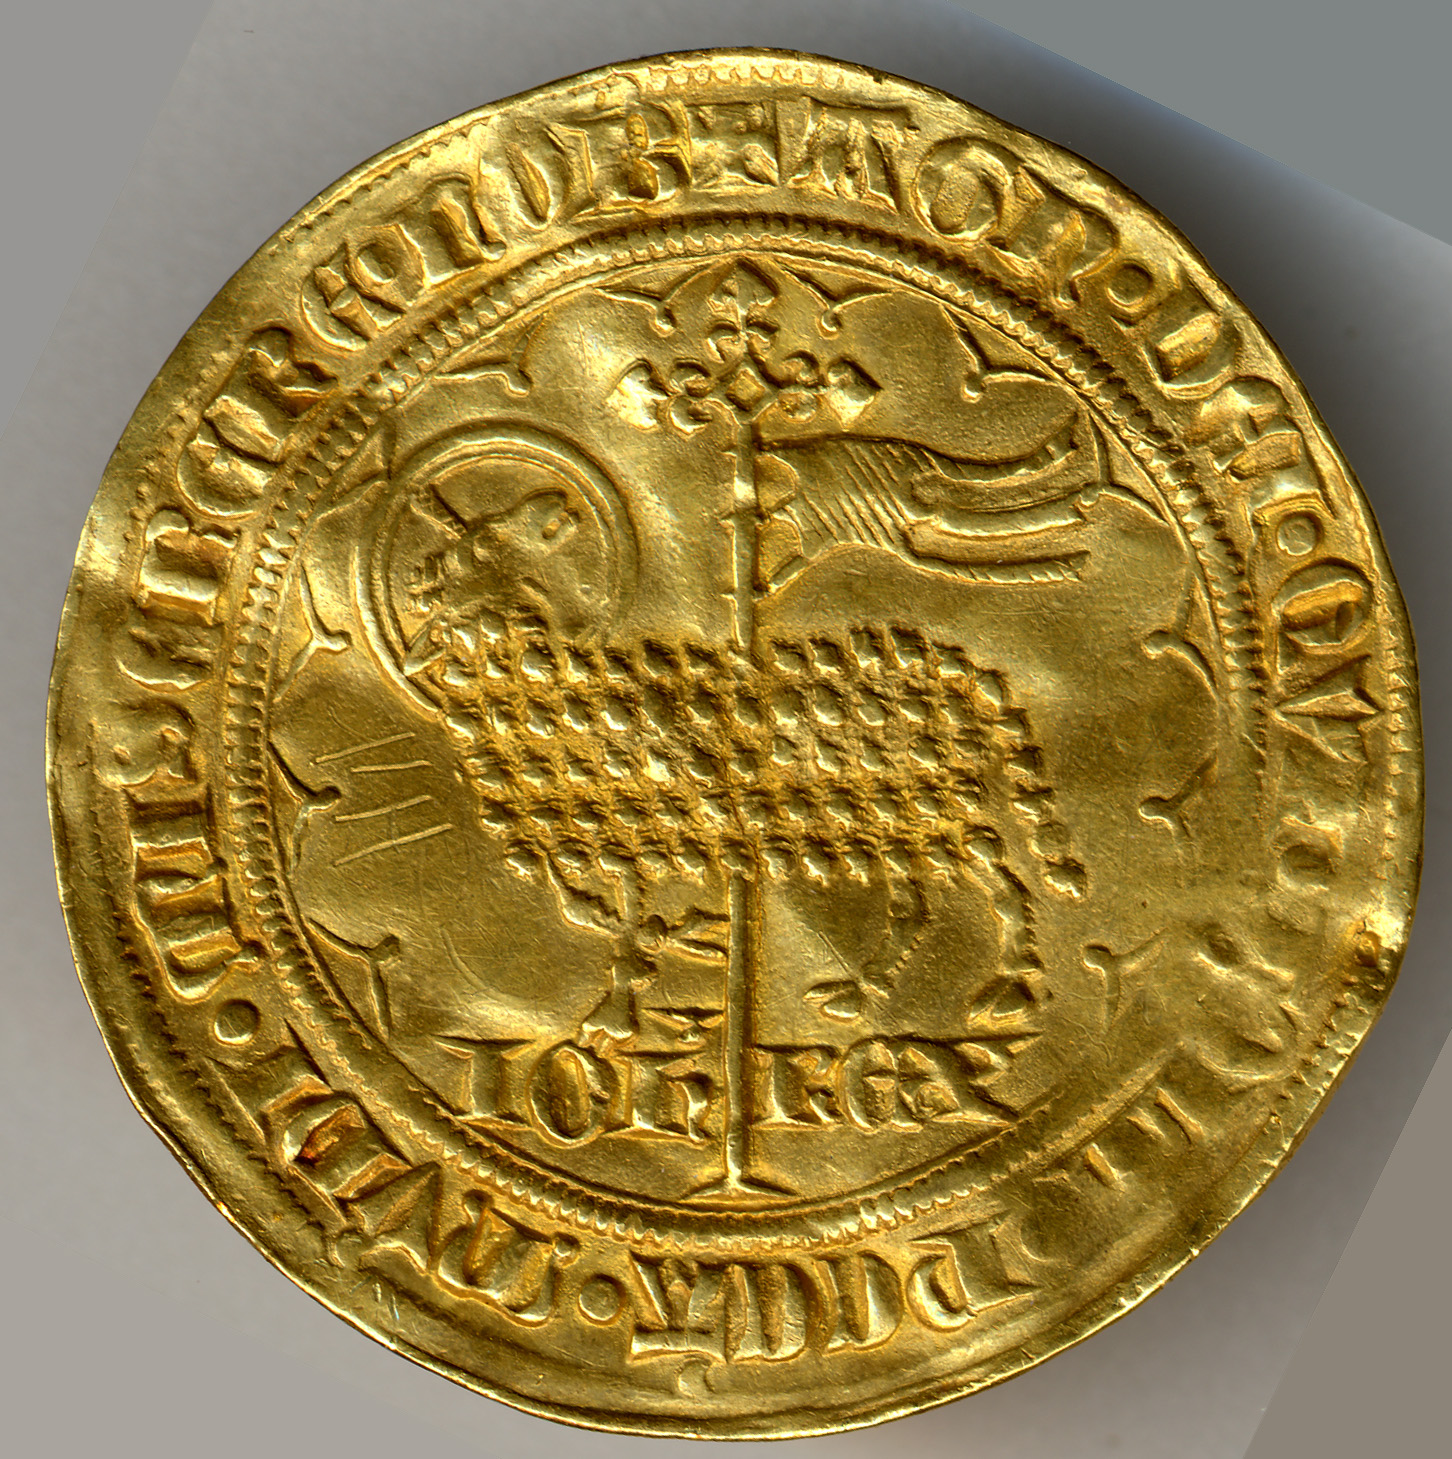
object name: coin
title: Mouton of Jean the Good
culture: french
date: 1350-1364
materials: gold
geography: france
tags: sheep